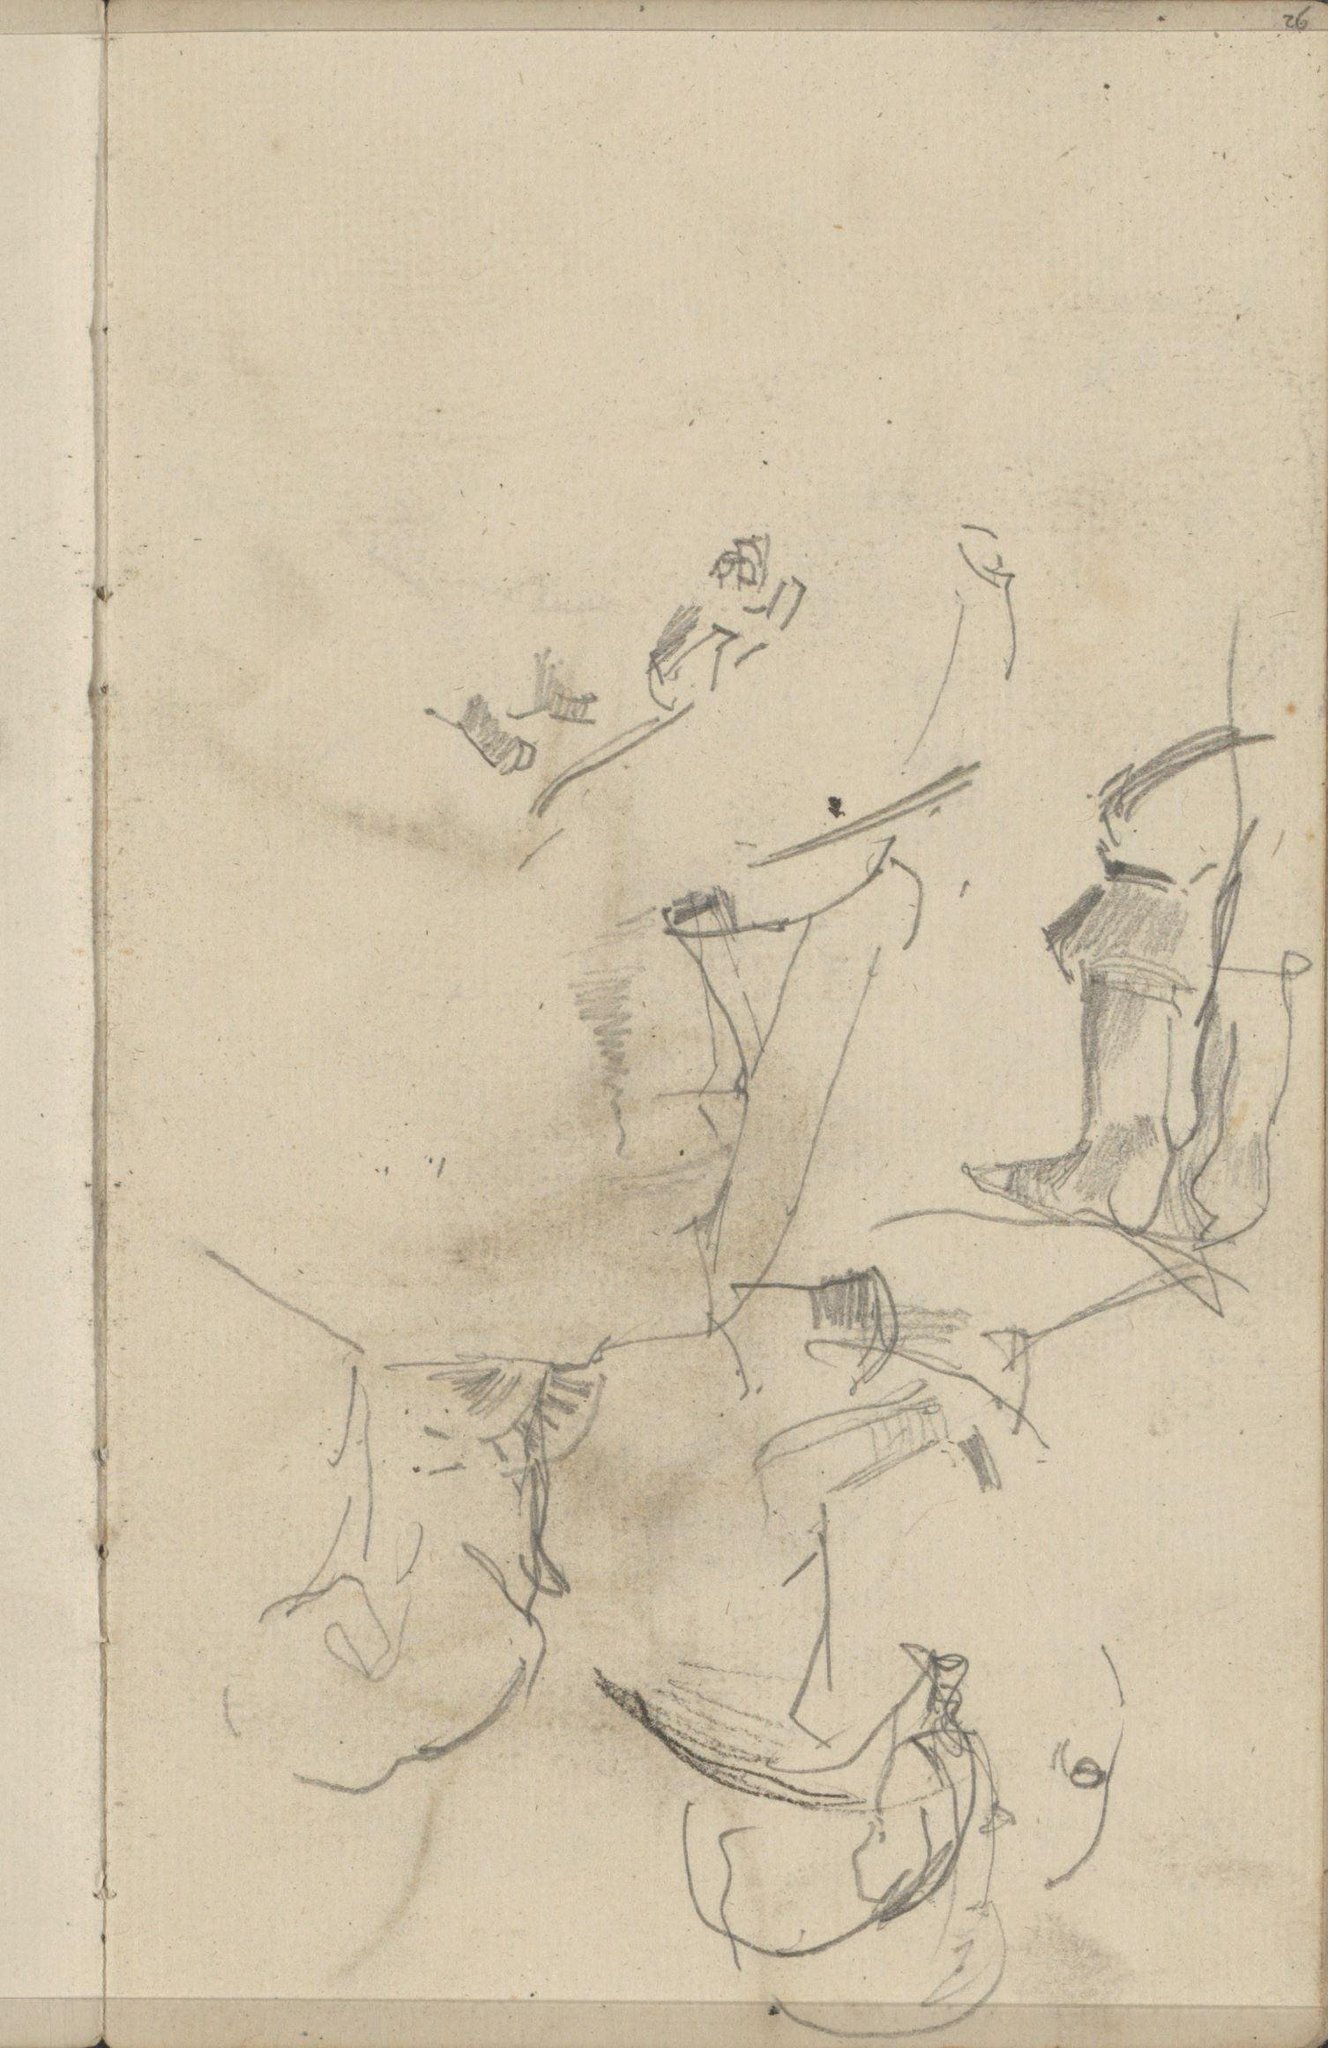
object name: sketchbook leaf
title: Studieblad met kinderen en een vrouw, op de rug gezien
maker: george hendrik breitner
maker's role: draughtsman, painter, print maker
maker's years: 1857-1923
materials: chalk, paper, pencil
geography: the hague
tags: adult woman (+ back view), child, girl (child between toddler and youth)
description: Pagina 26 uit een schetsboek met 28 bladen.